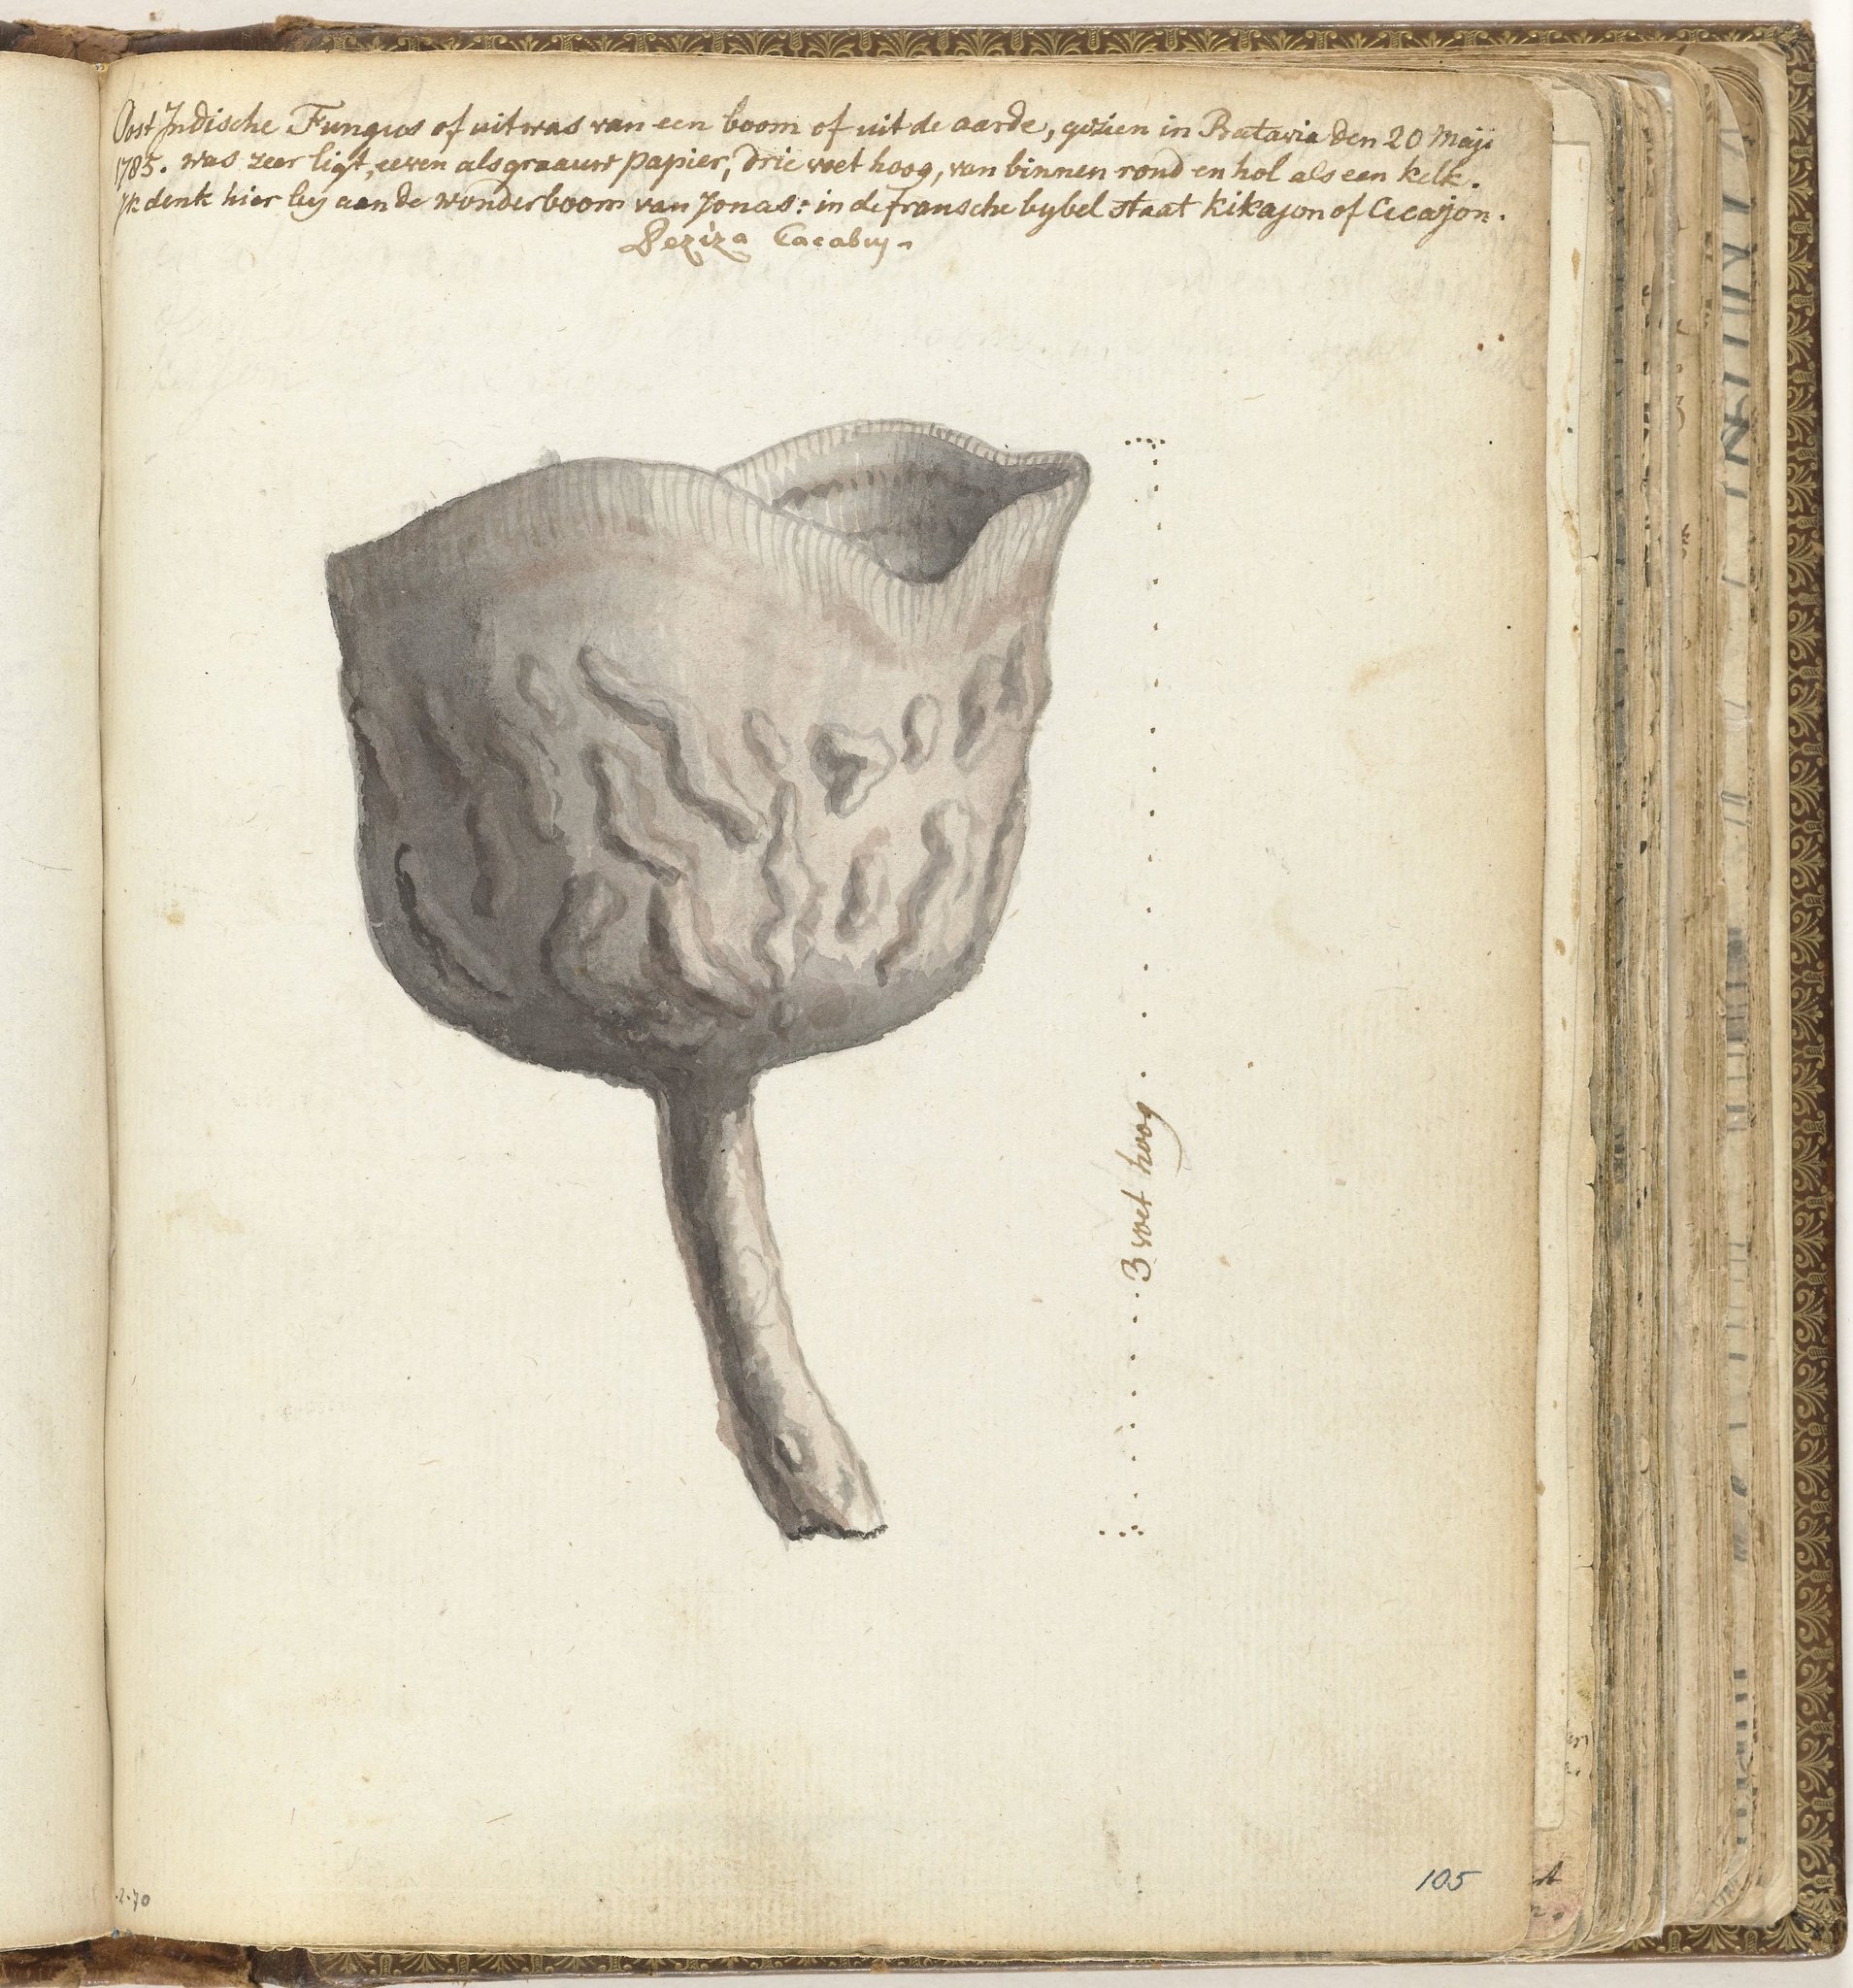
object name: drawing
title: Javaanse paddestoel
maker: jan brandes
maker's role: draughtsman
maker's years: 1743-1808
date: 1785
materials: paper, pencil, watercolor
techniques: brush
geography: jakarta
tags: mushrooms, batavia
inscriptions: inscription: ‘Oost Indische Fungus of uitwas van een boom of uit de aarde, gezien in Batavia den 20 Maji 1785. Was zeer ligt, even als graauw papier, drie voet hoog, van binnen rond en hol als een kelk. Ik denk hierby aan de wonderboom van Jonas: in de fransche bybel staat kikajon of cucajon. Peziza Cacabus’, inscription: ‘3 voet hoog’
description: Kleurtekening van een groeisel door de tekenaar gevonden op Java in de vorm van een kelk met een steel. Met opschrift. Onderdeel uit het schetsboek van Jan Brandes, dl. 2 (1808), p. 105.